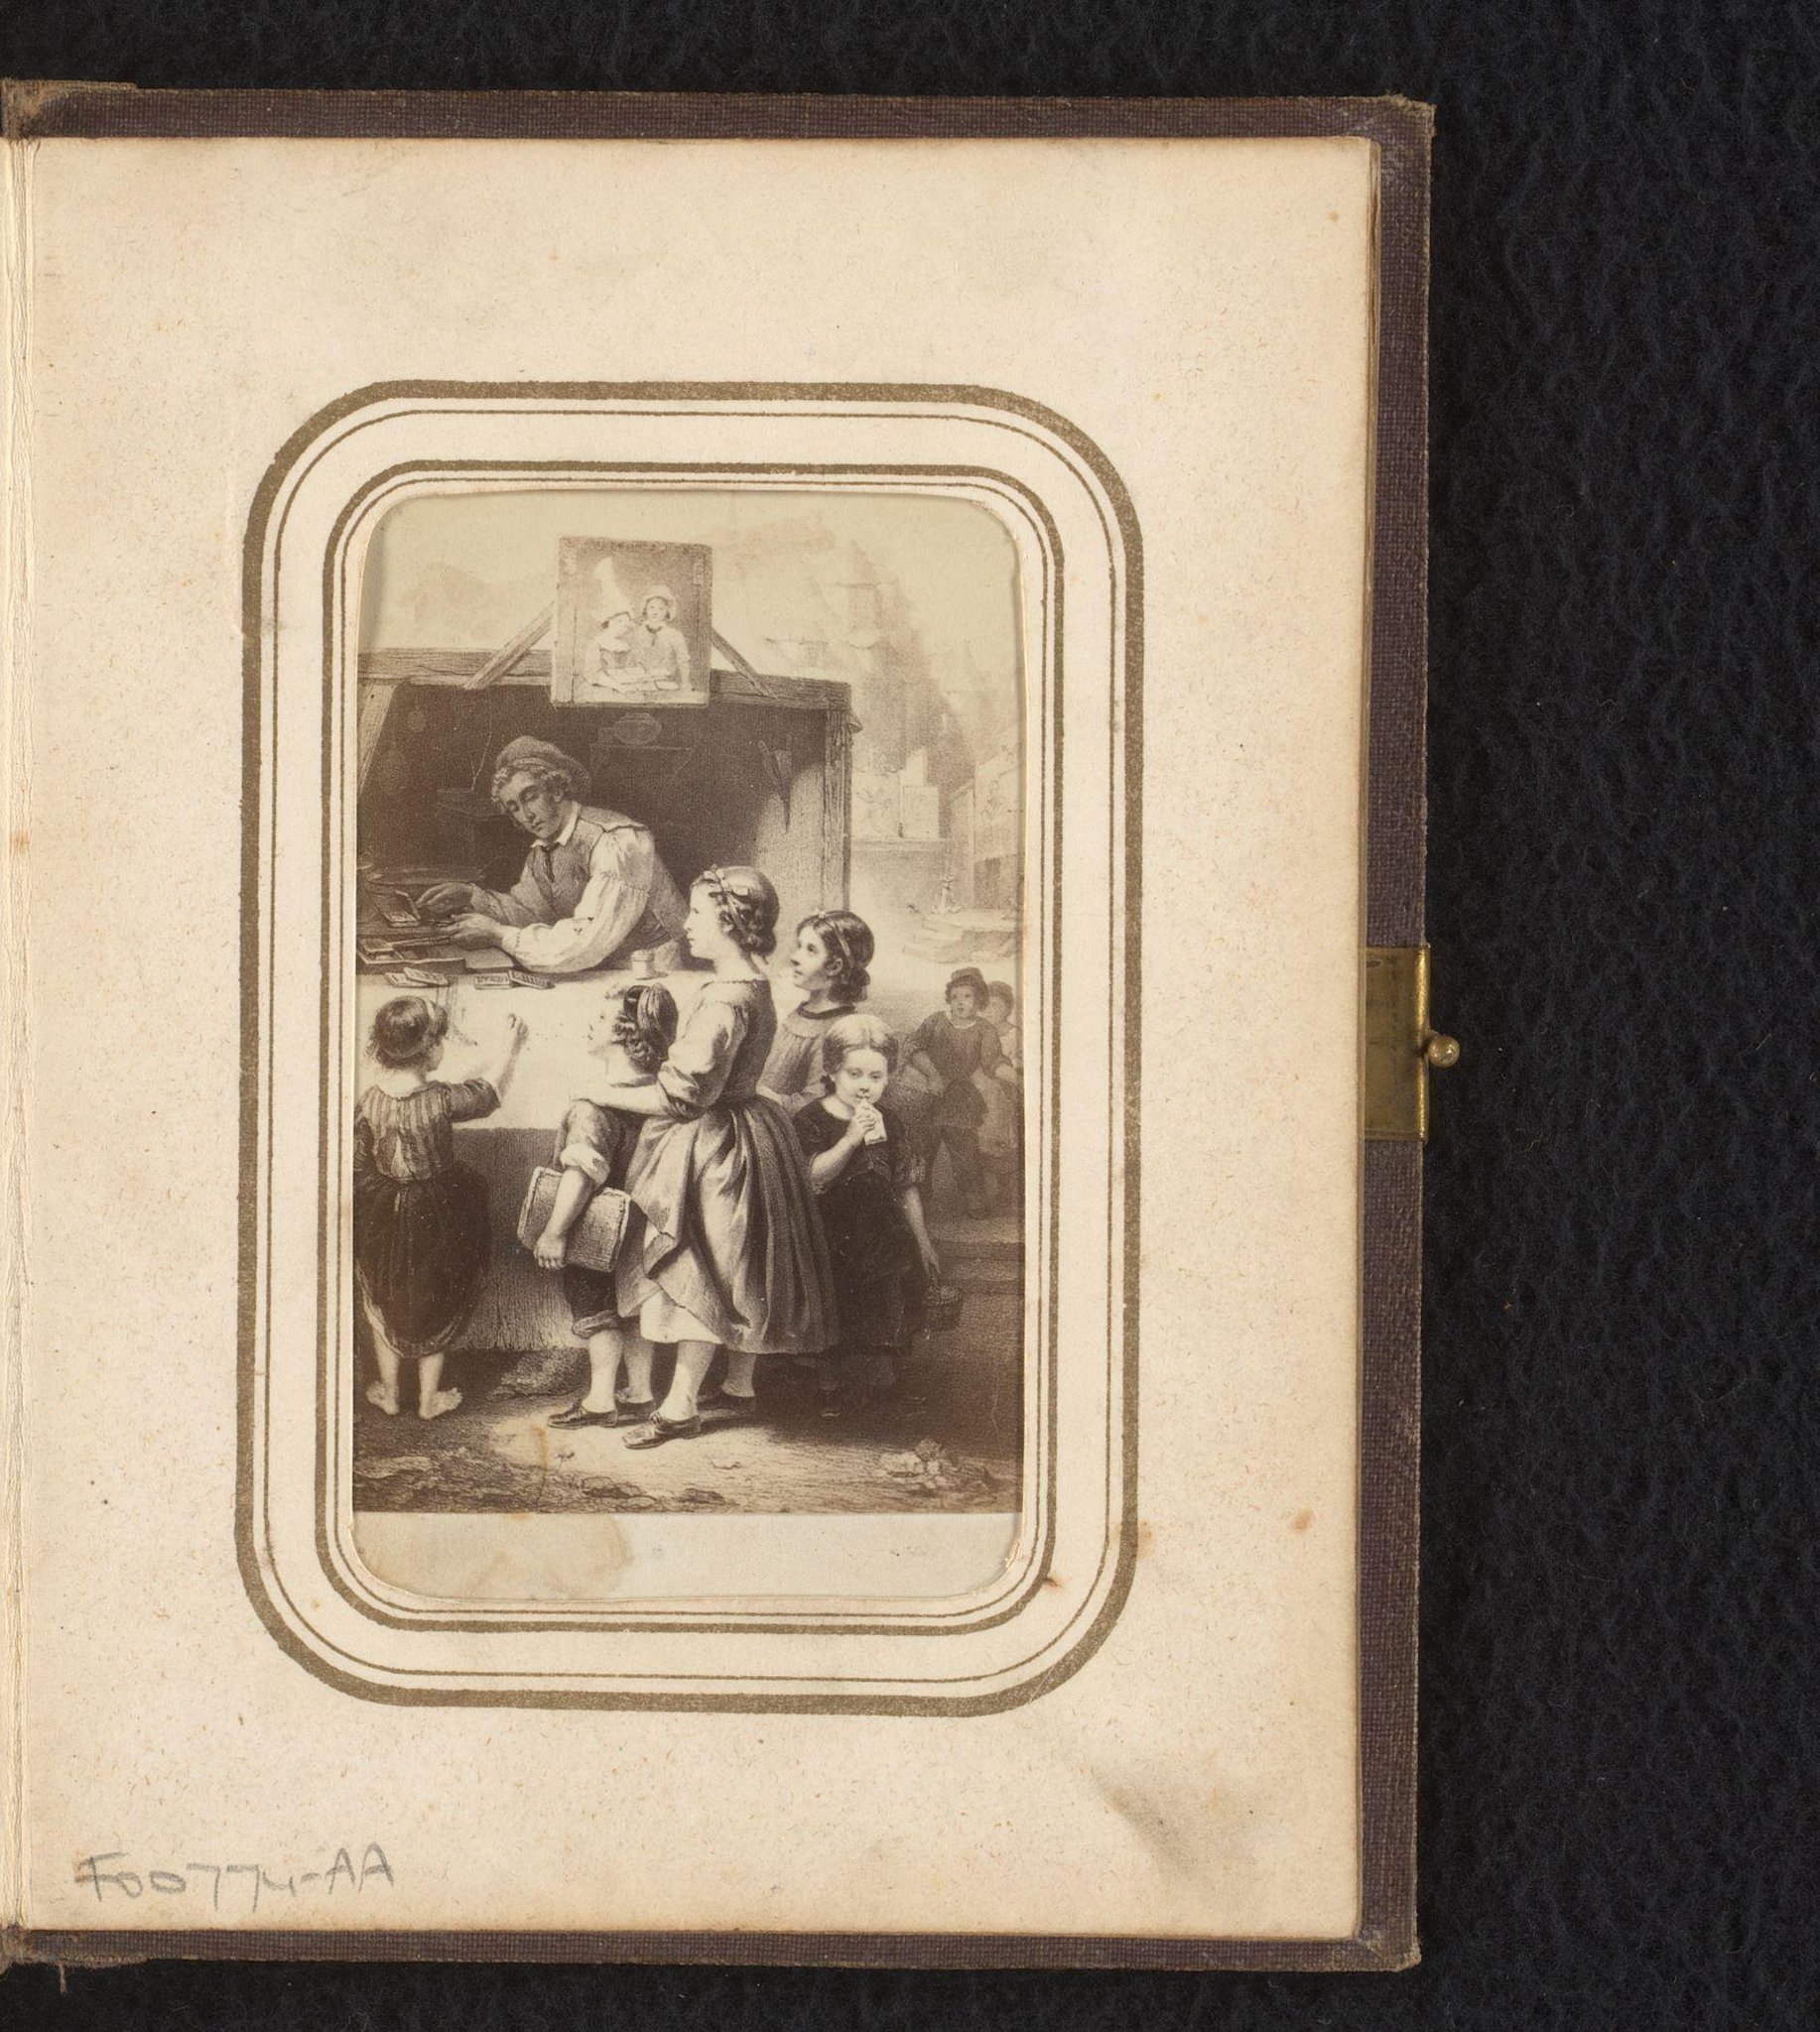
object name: reproduction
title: Fotoreproductie van een schilderij van kinderen bij de marktkraam van een wafelbakker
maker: Anonymous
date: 1850-1900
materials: cardboard, photographic support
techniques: albumen print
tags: stall, booth (~ market), baker, waffles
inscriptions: annotation: ‘1889./ In Waffelk[...] Gaüken’